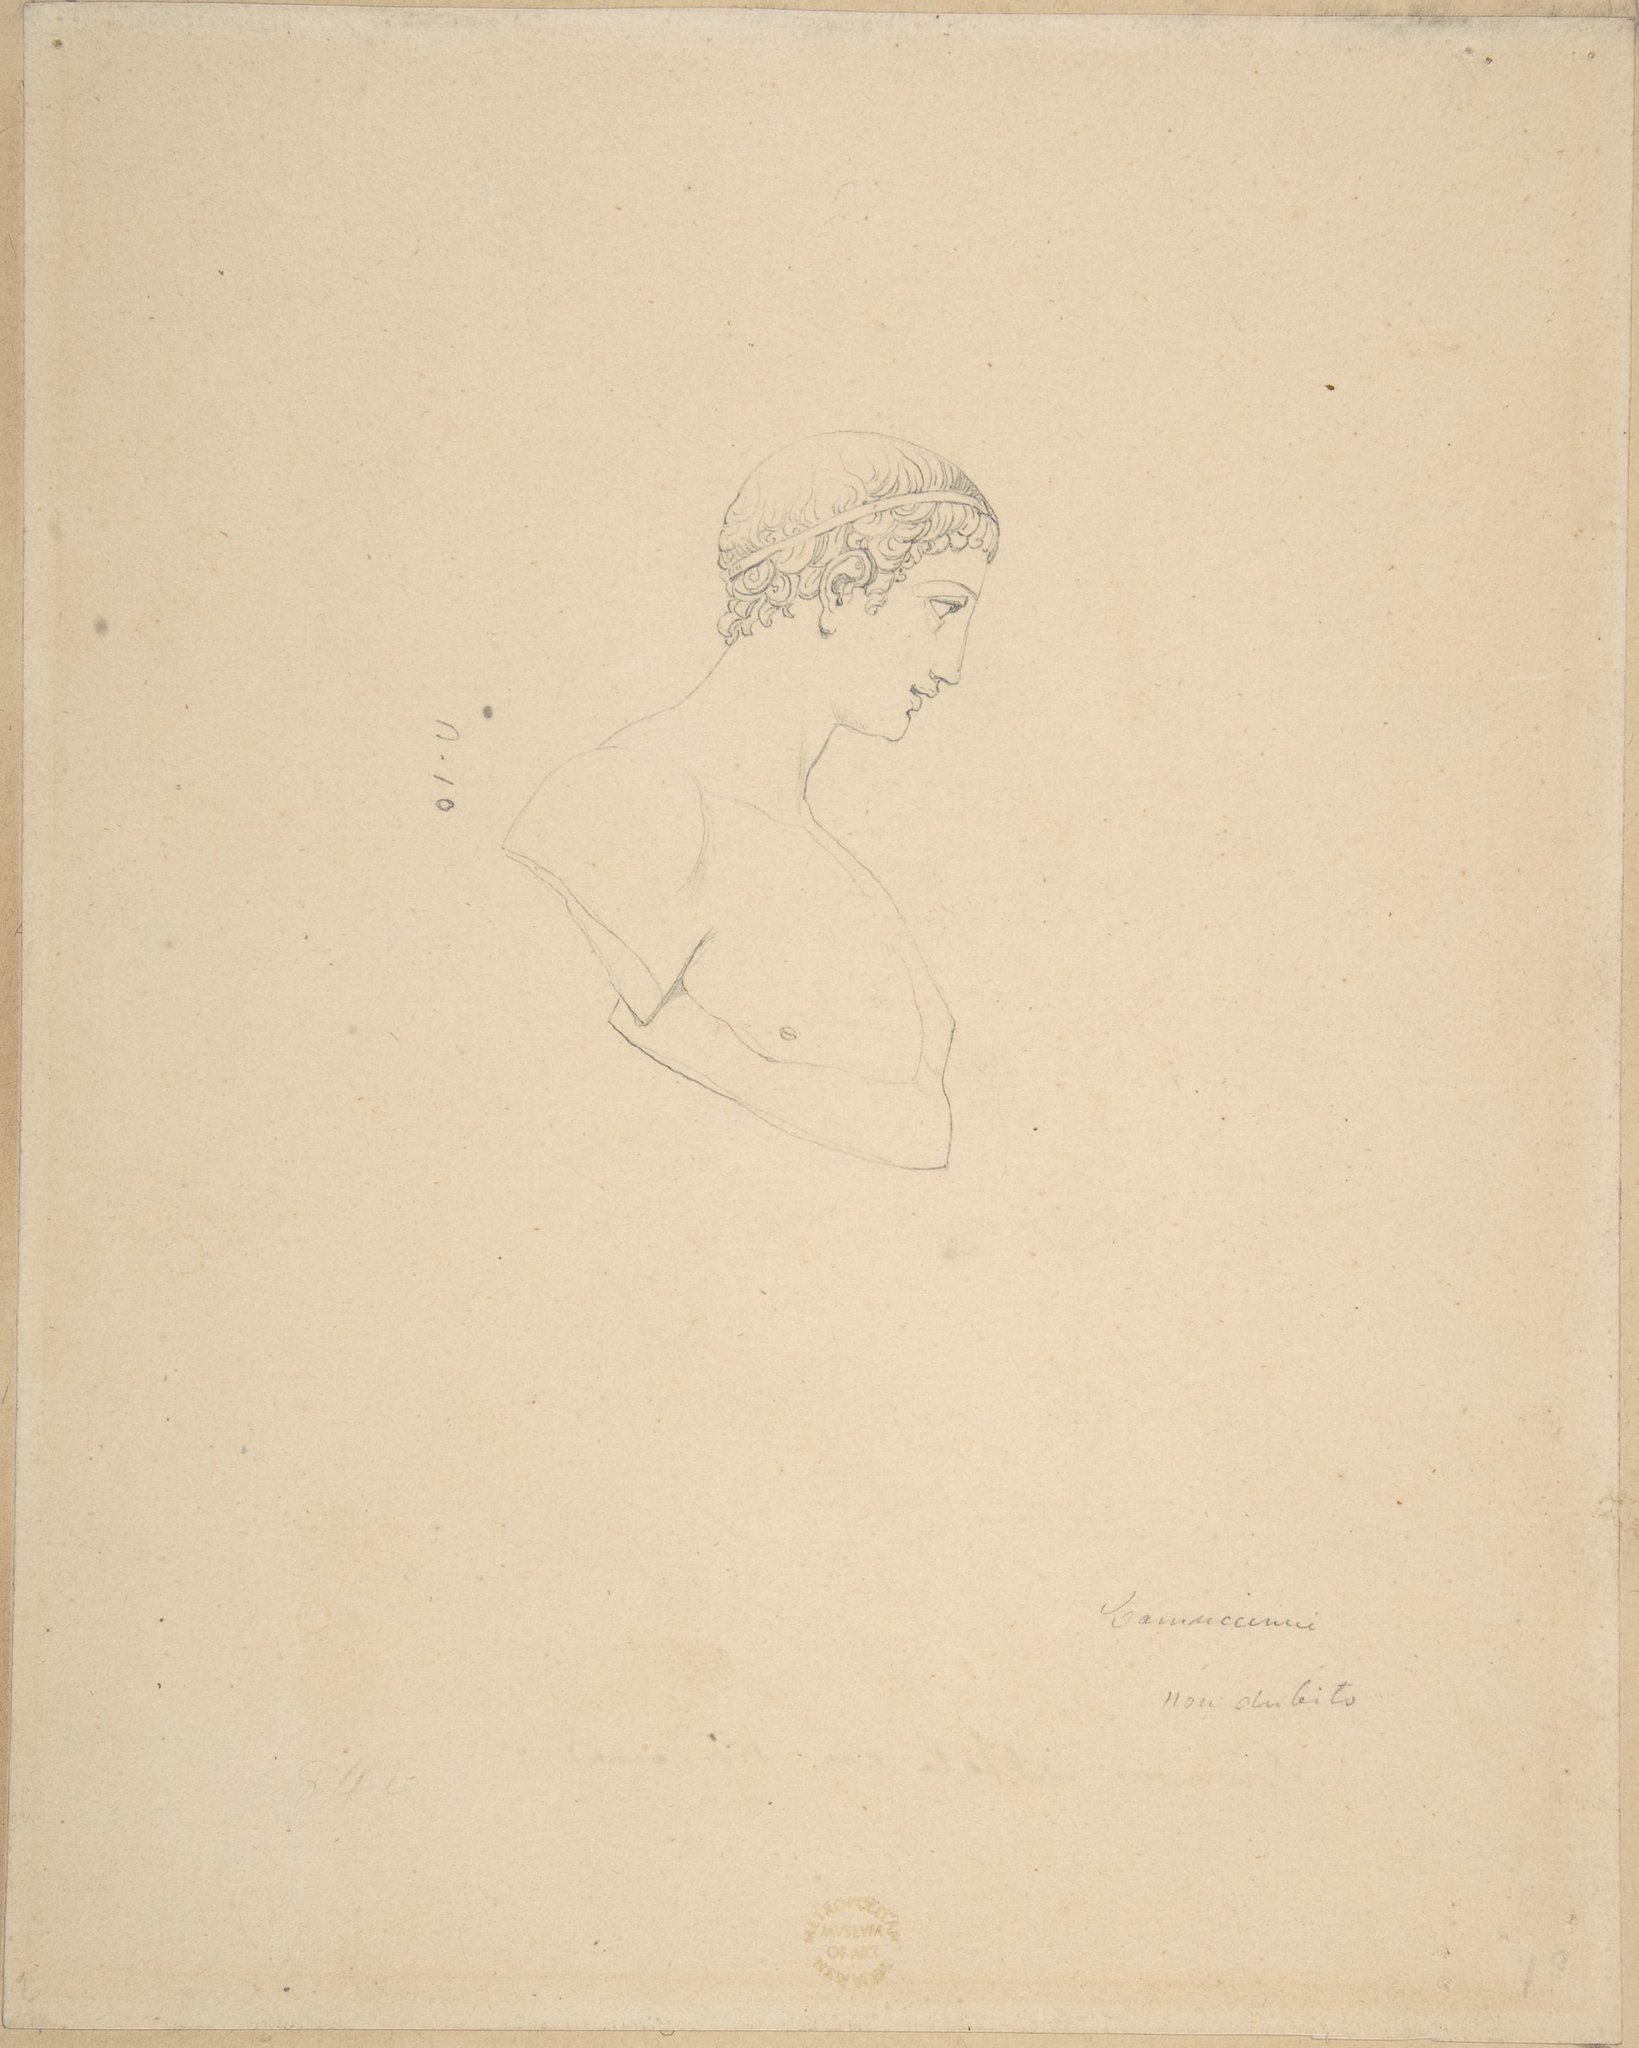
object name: drawing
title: Classical Male Bust in Profile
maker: vincenzo camuccini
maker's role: artist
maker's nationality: italian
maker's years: 1771-1844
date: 1795-1844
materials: graphite, ink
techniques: brush, pen, wash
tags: men,profiles